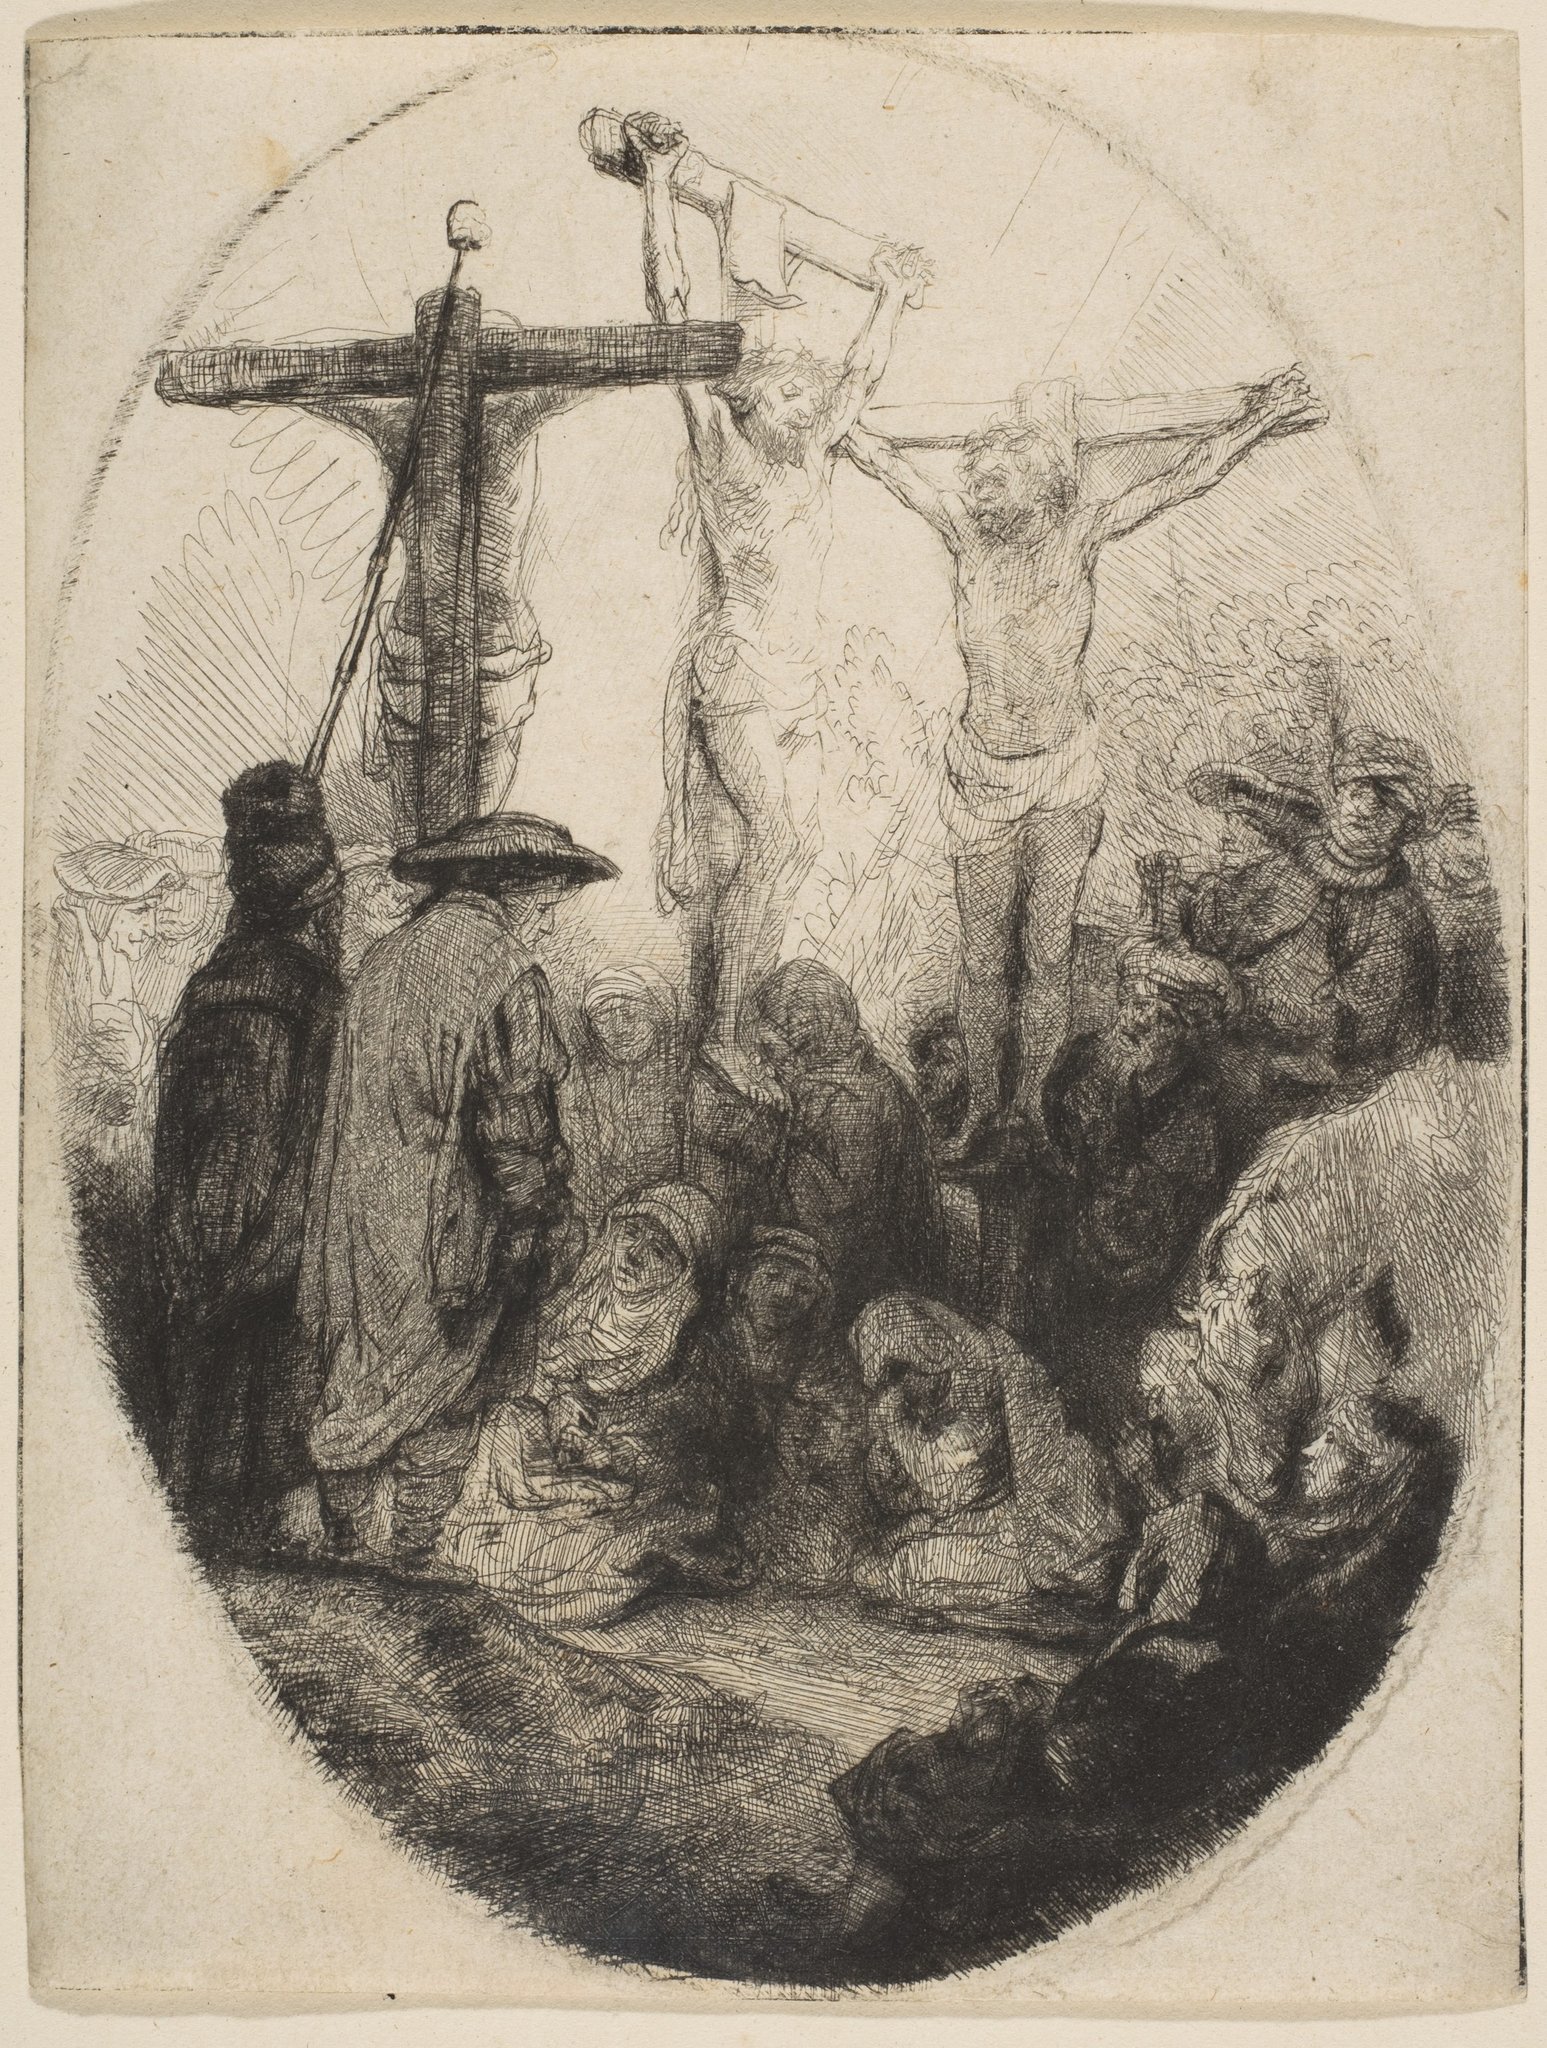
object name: print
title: Christ Crucified Between Two Thieves; oval plate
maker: rembrandt van rijn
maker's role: artist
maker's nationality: dutch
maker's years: 1606-1669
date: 1641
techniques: drypoint, etching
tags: men,christ,crucifixion